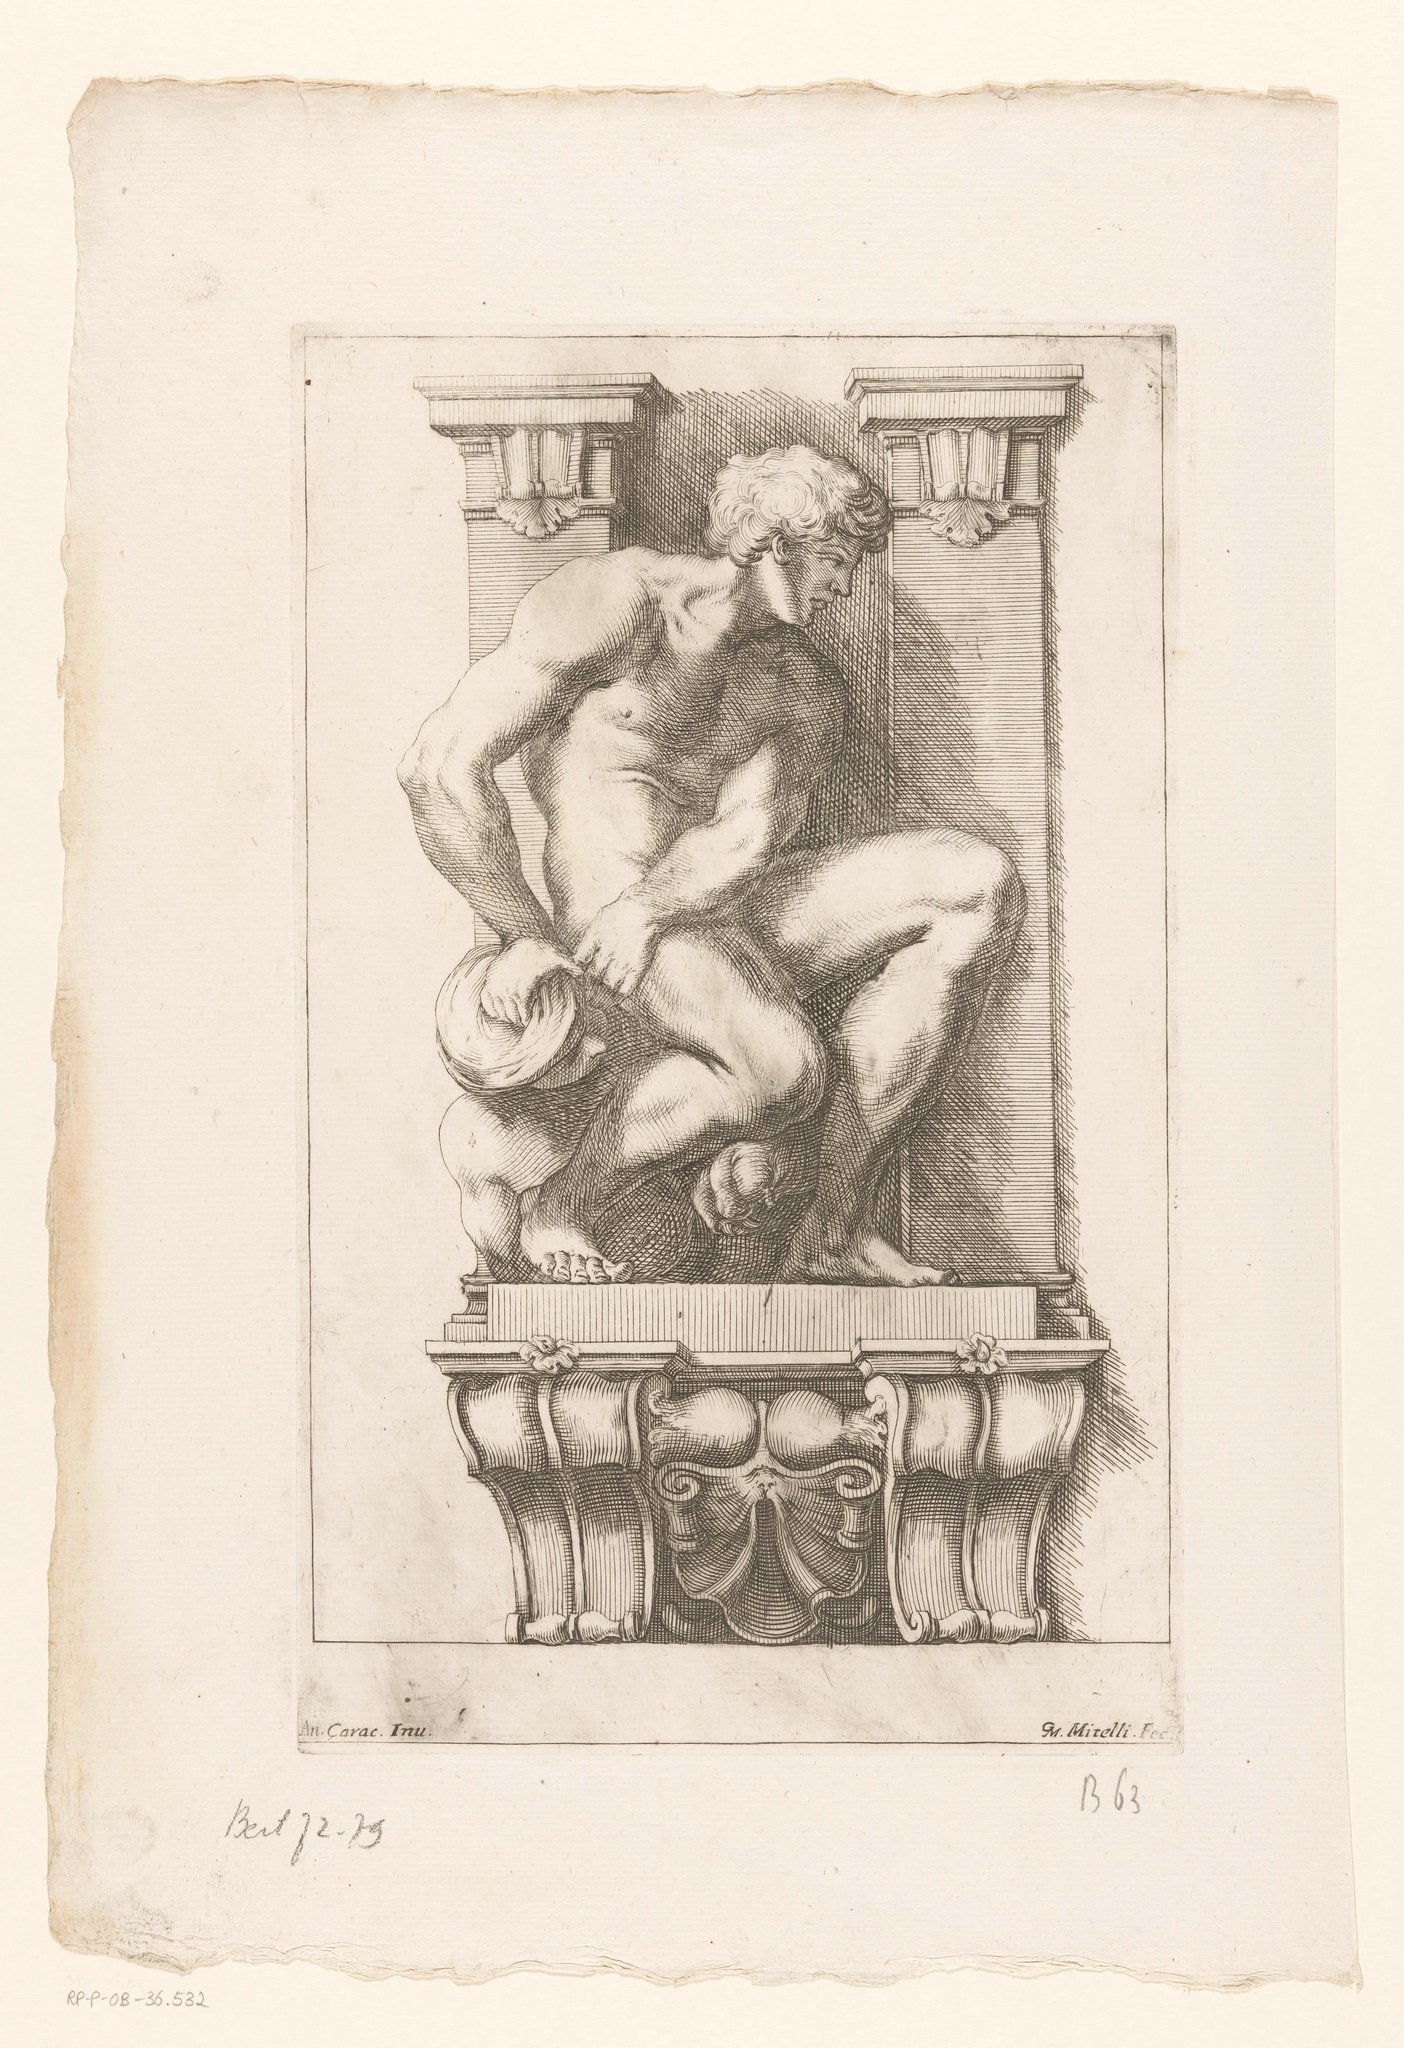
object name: print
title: L'Enea Vagante pitture dei Caracci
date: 1663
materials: paper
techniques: etching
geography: rome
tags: the (nude) human figure; 'corpo humano' (ripa), other architectural details (console), harpies (classical mythology)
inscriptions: collector's mark: Lugt 2228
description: Deze prent maakt deel uit van een reeks van 20 prenten (+ titelprent) naar de fresco's door de Carracci's in Palazzo Fava Ghisilieri te Bologna.